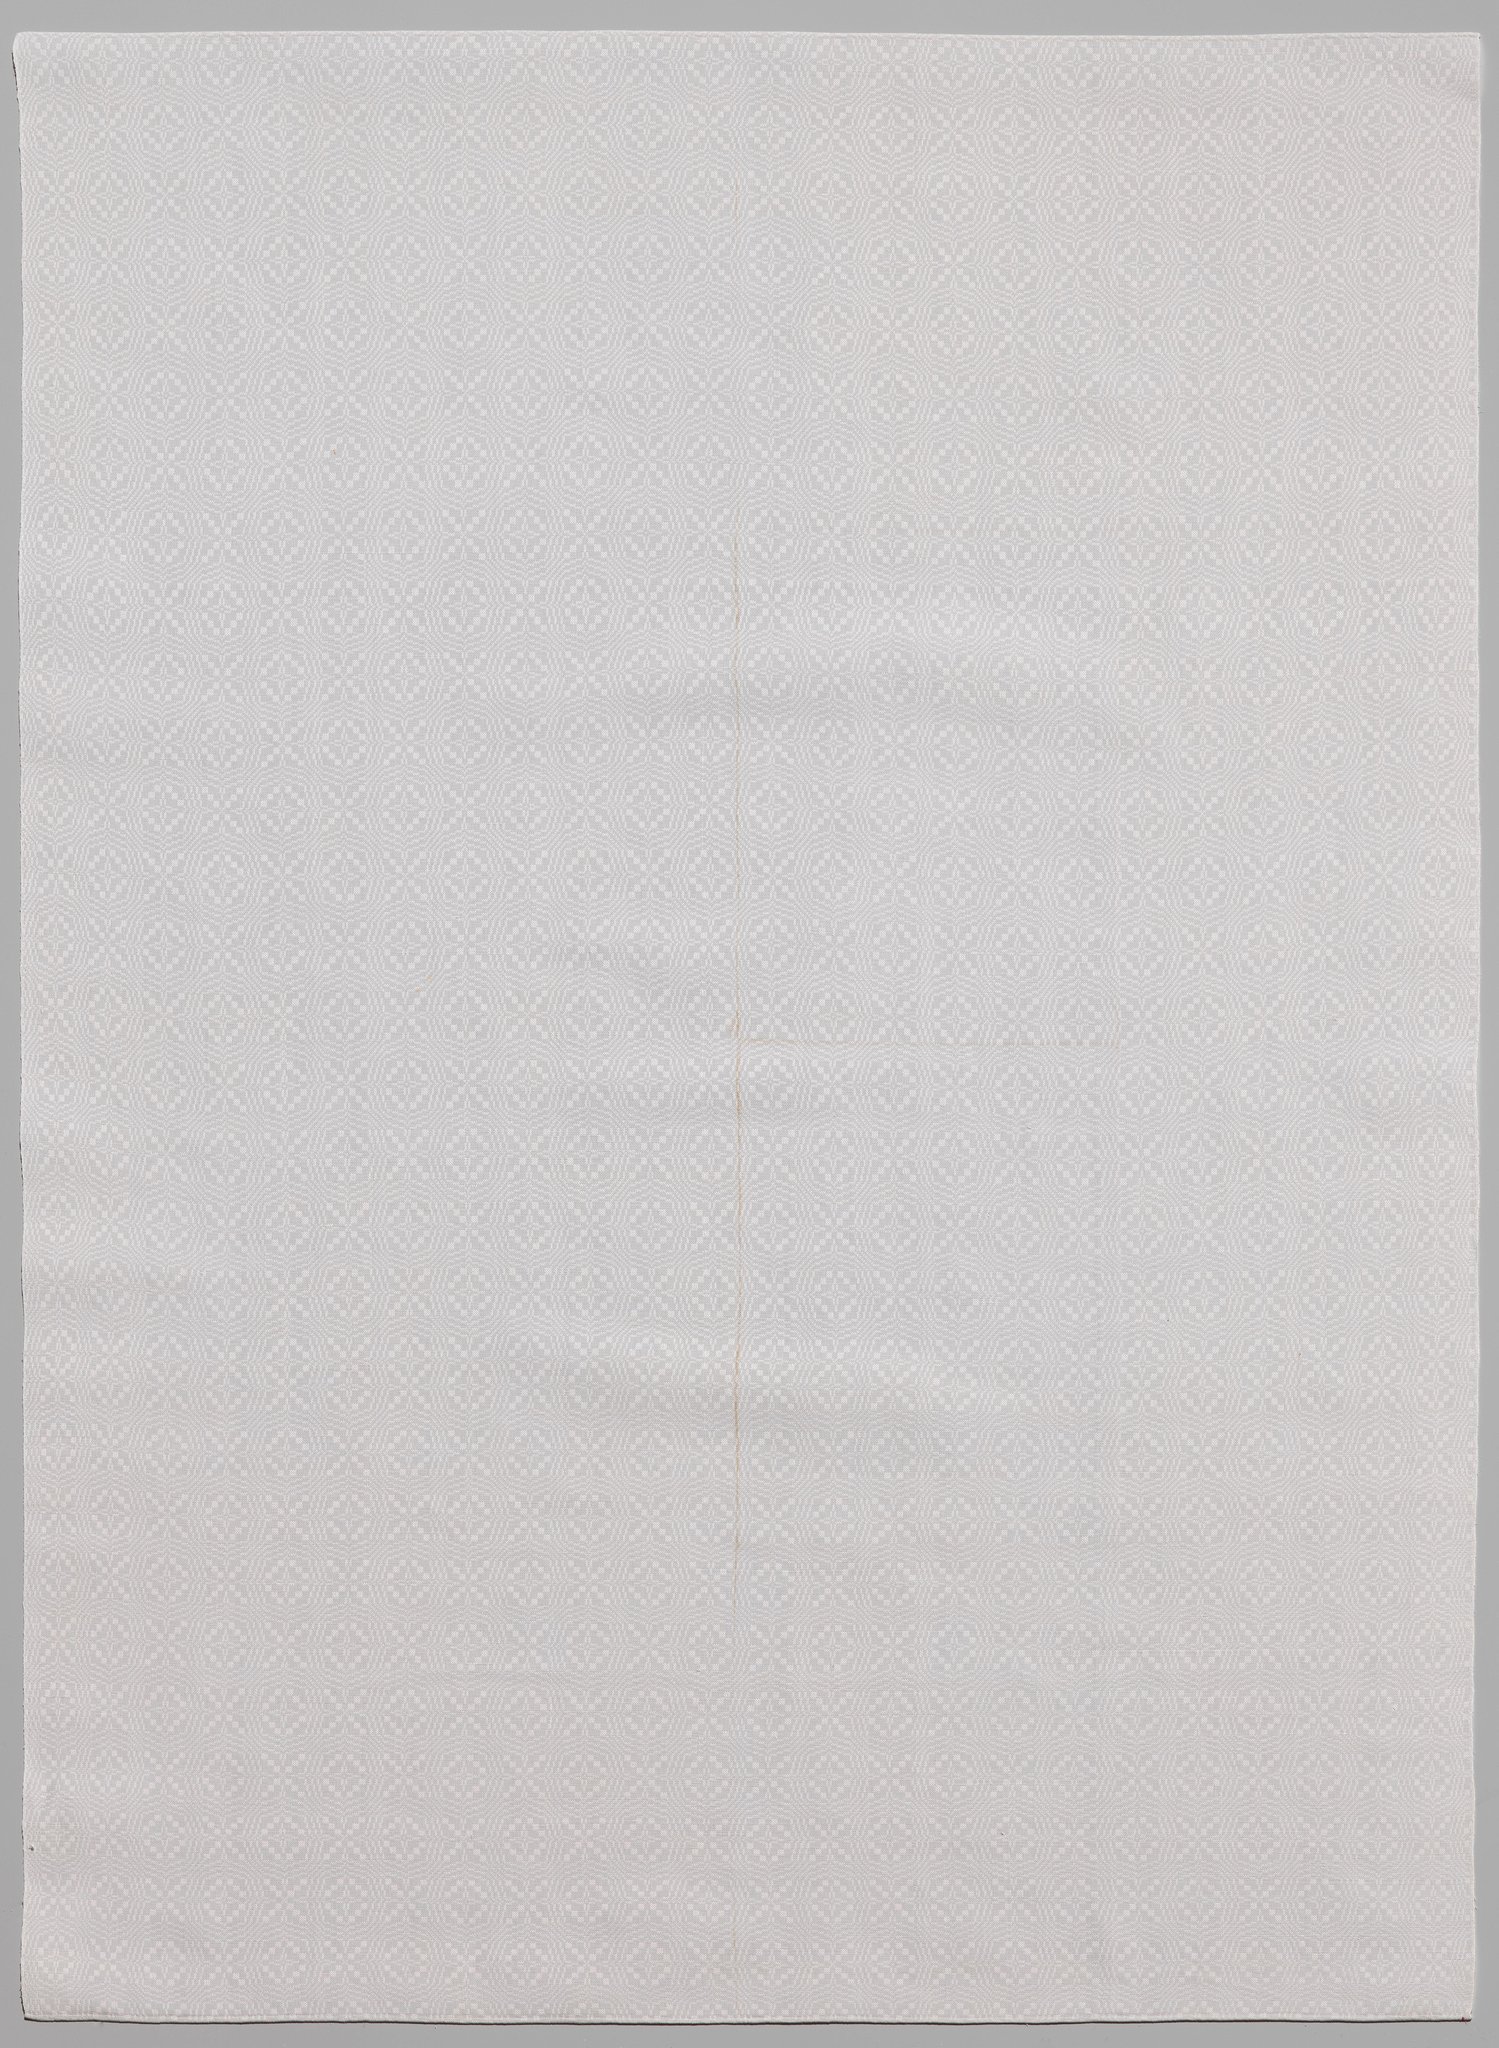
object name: napkin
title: Servet van linnen met pellenpatroon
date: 1600-1699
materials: linen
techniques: twill, peeled fabric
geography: northern netherlands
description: wit linnen servet met een pellen patroon in keper z.g. 'omslingerde molenwiek'